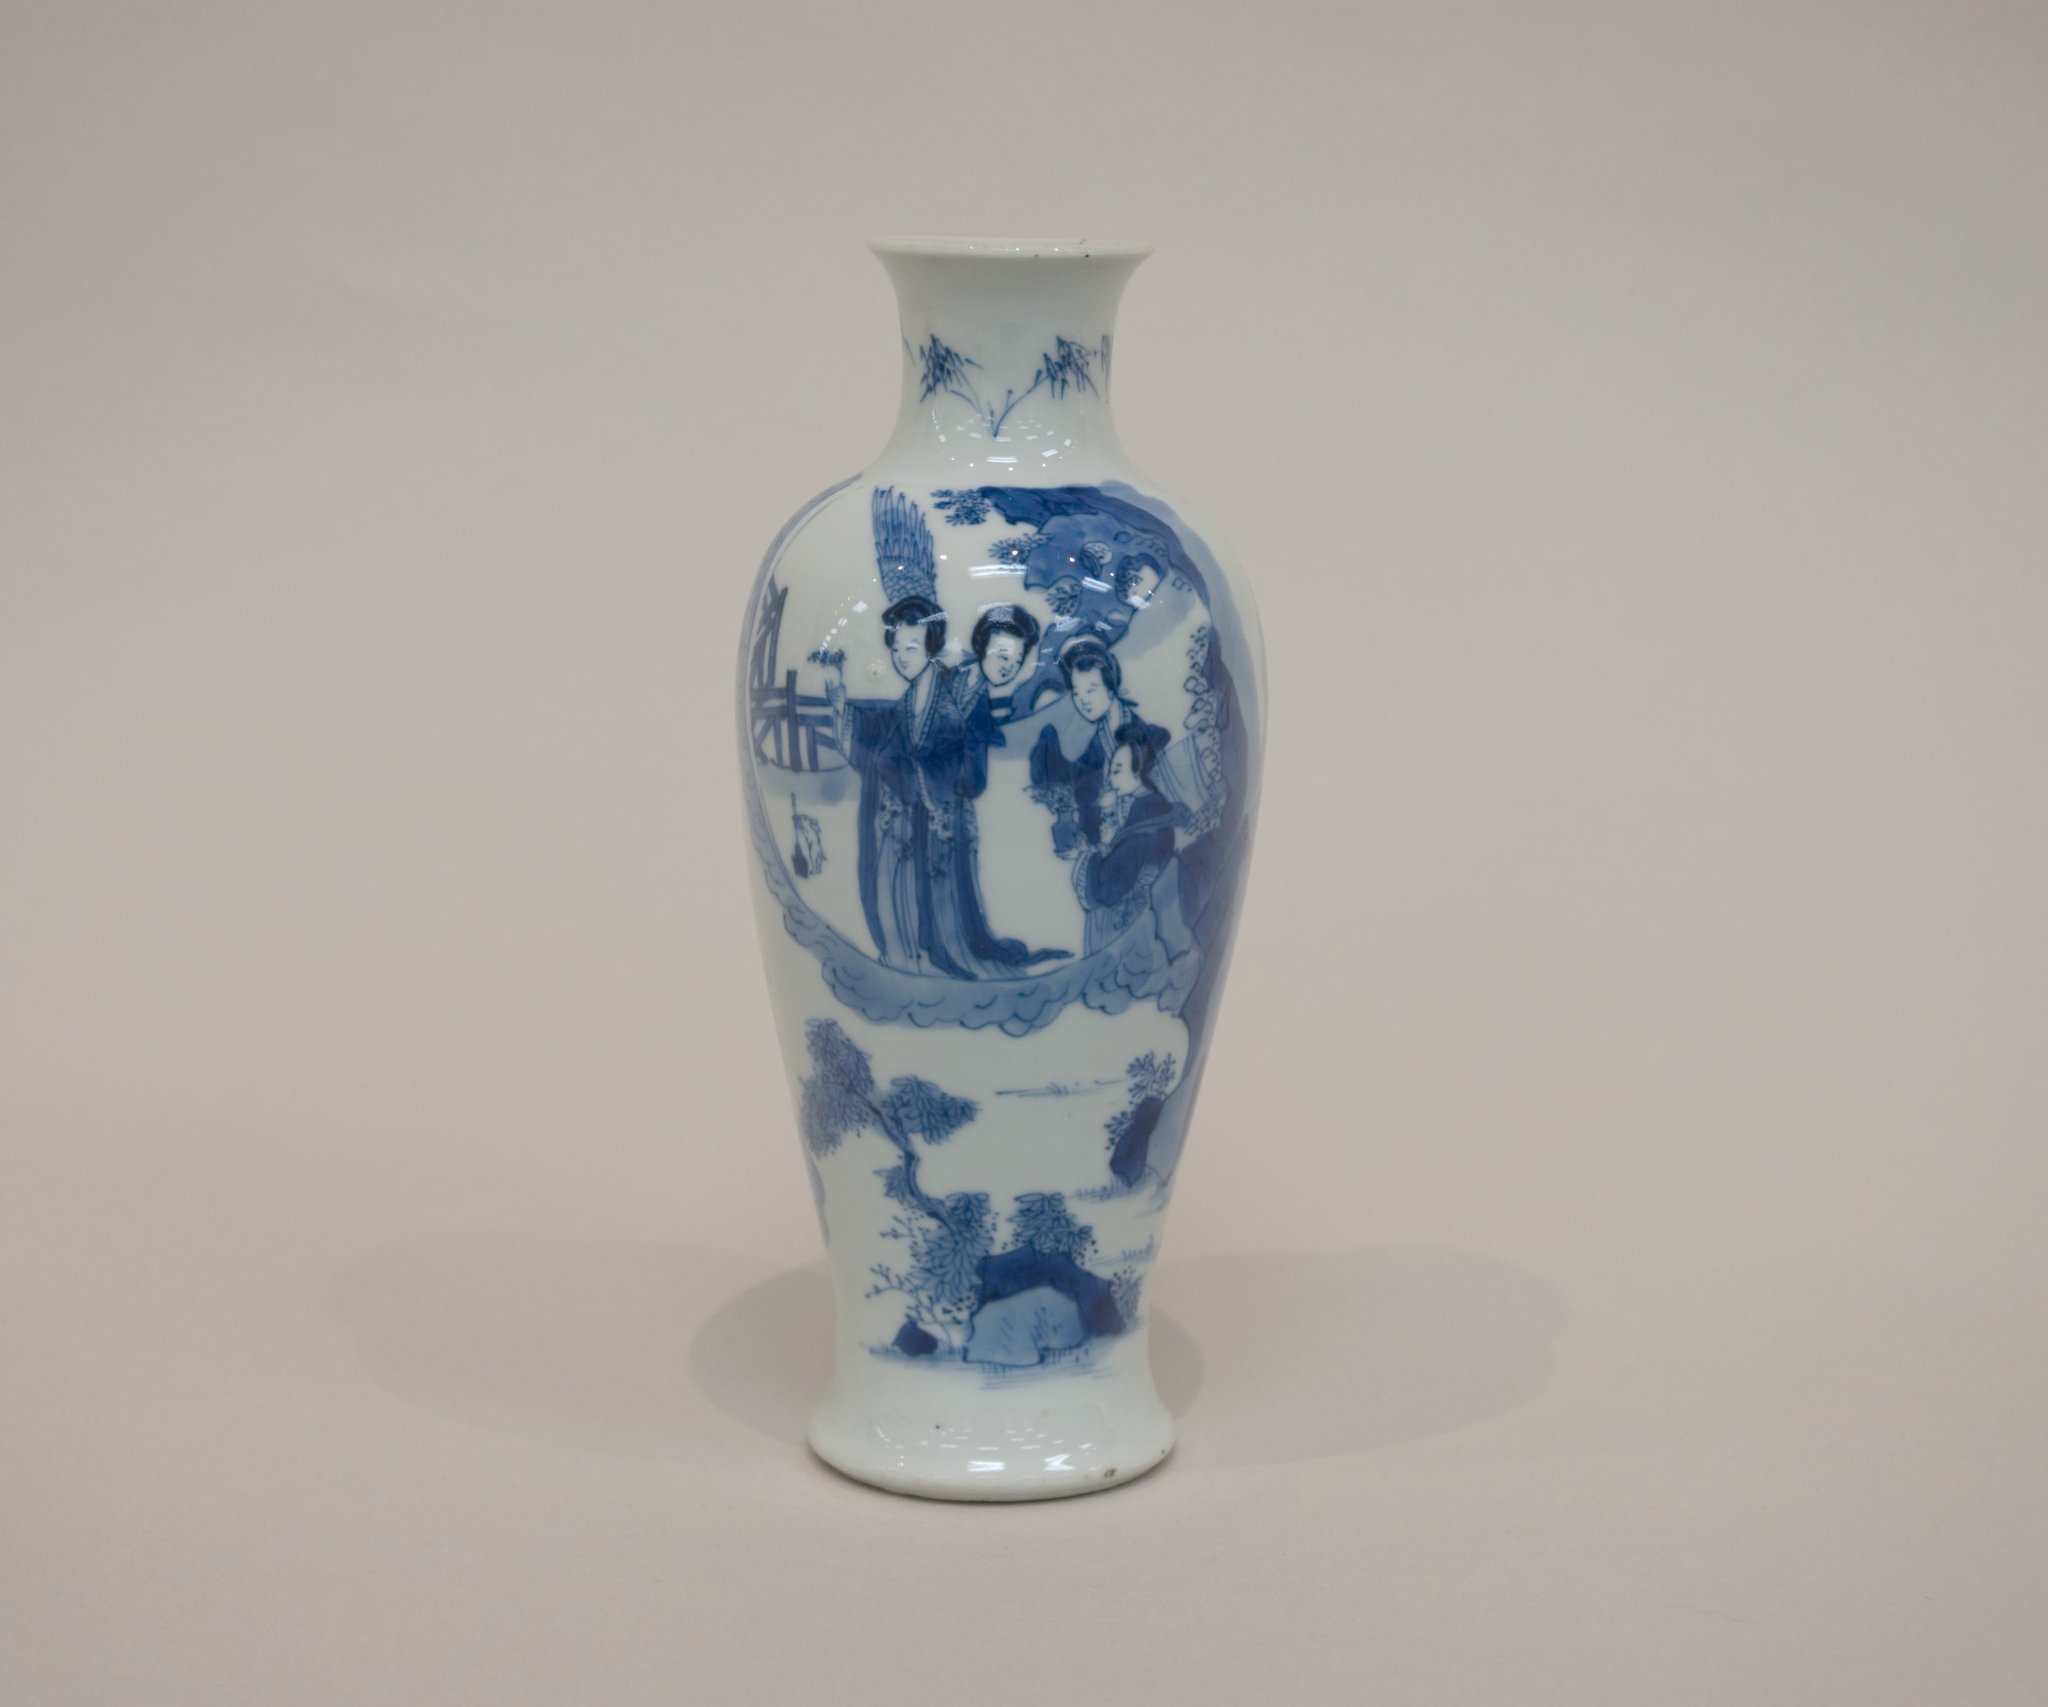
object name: vase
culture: chinese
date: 1667-1733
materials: porcelain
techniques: painting, underglaze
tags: women,trees